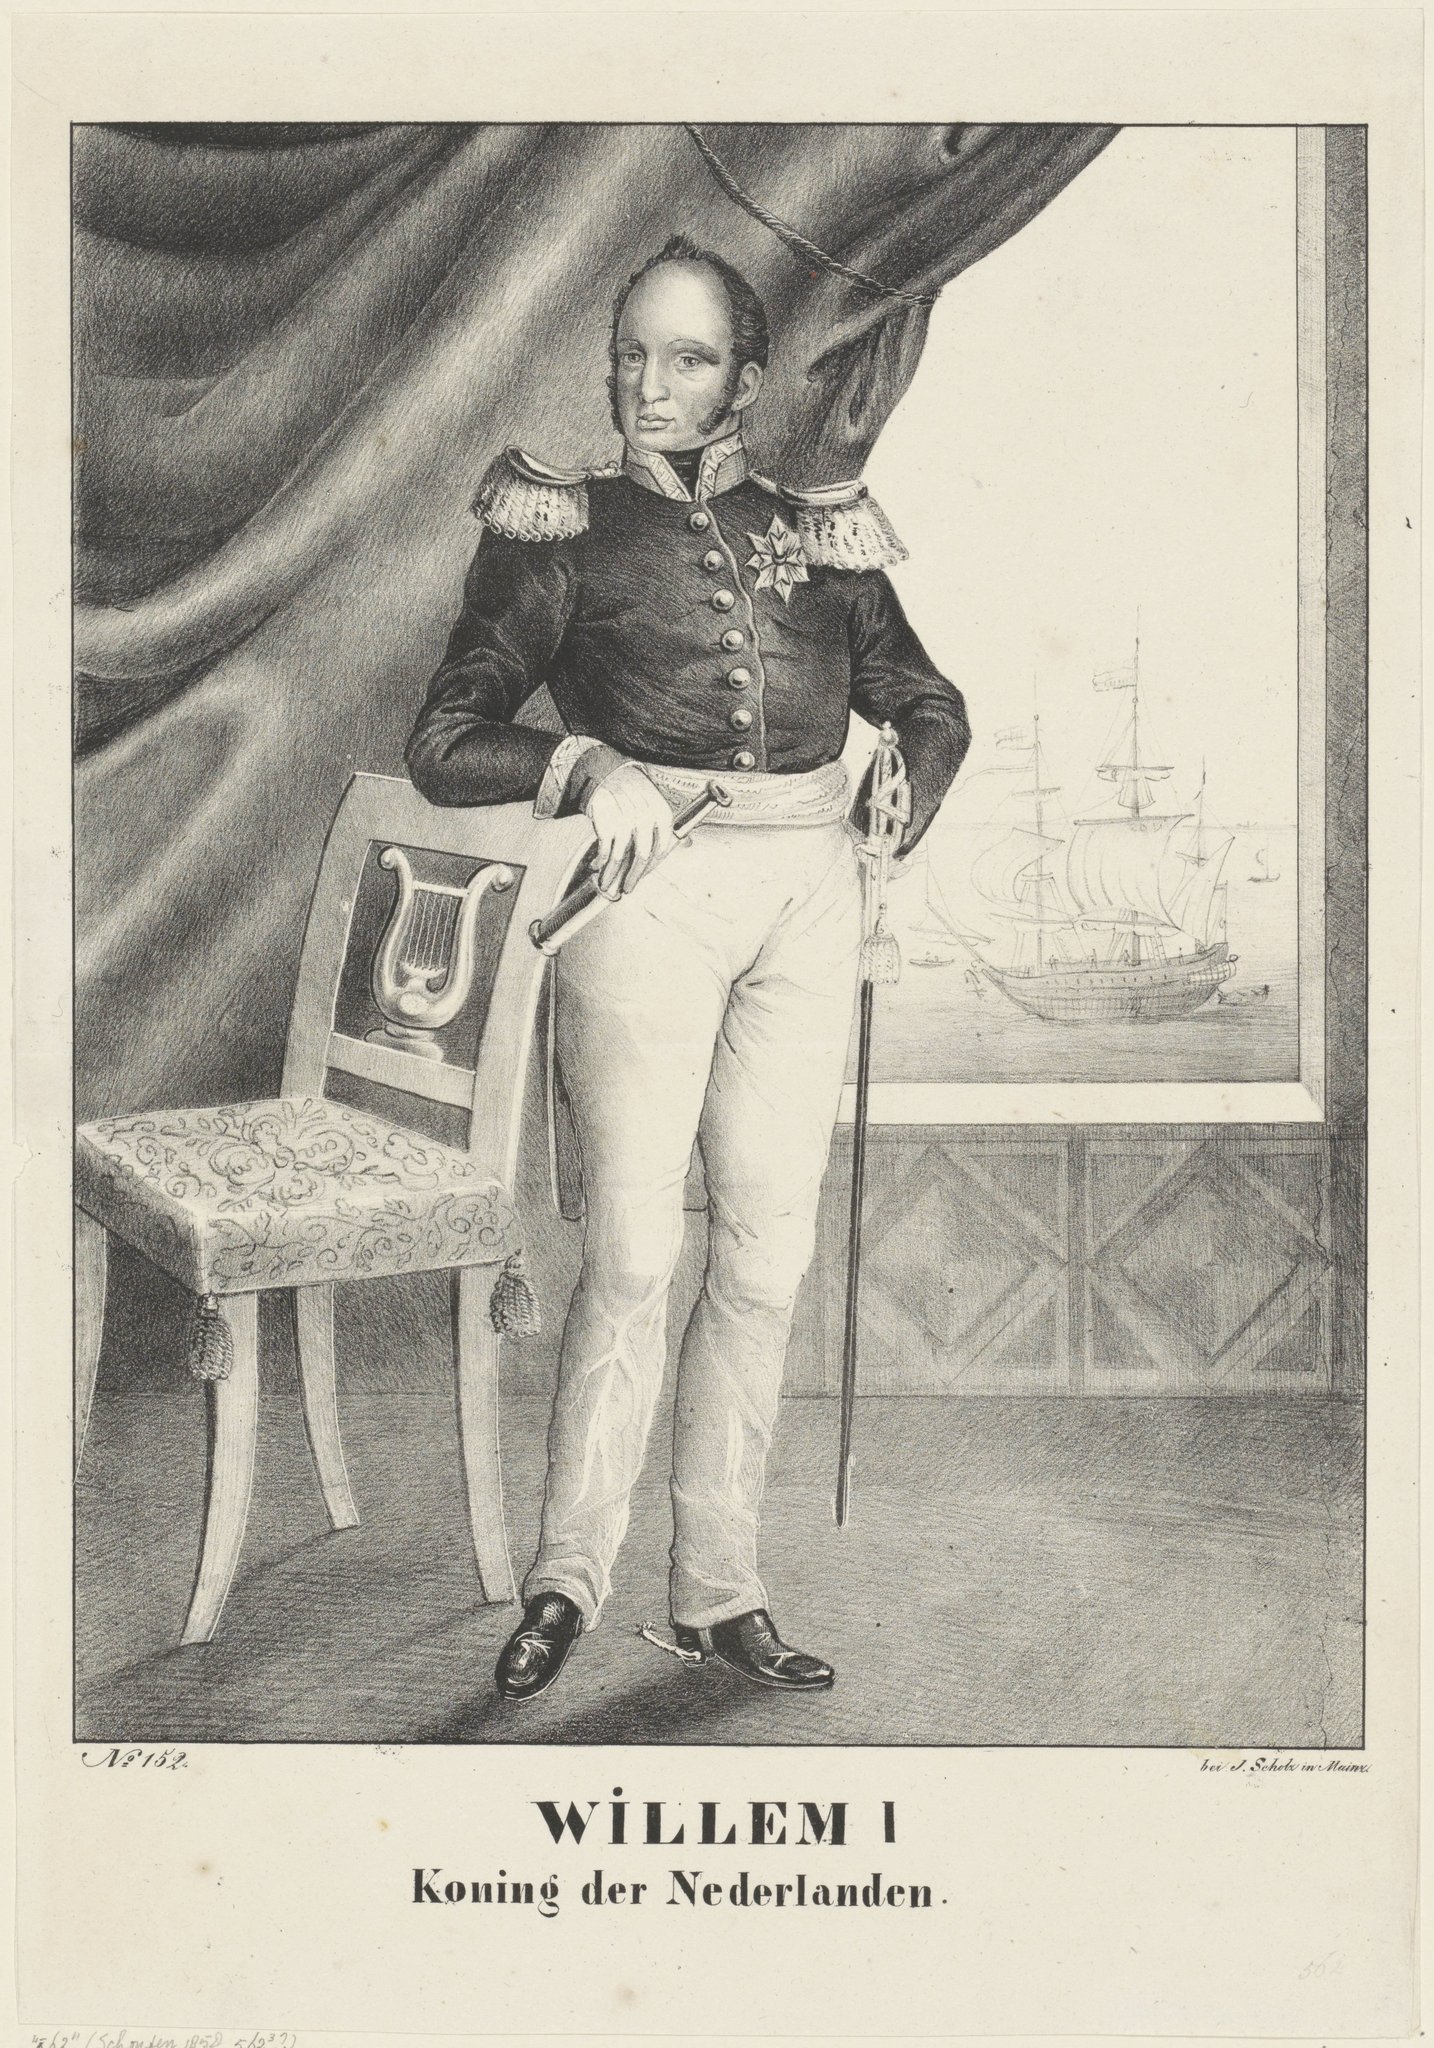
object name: print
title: Portret van Willem I Frederik, koning der Nederlanden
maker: Anonymous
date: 1829-1880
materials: paper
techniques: lithograph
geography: mainz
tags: berlin, william i of the netherlands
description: Portret van Willem I Frederik. Hij staat in een vertrek naast een stoel. In zijn rechterhand een mono verrekijker. Op de achtergrond een rivier met schepen. In de ondermarge zijn naam en titel. Linksonder 'No 152.'.